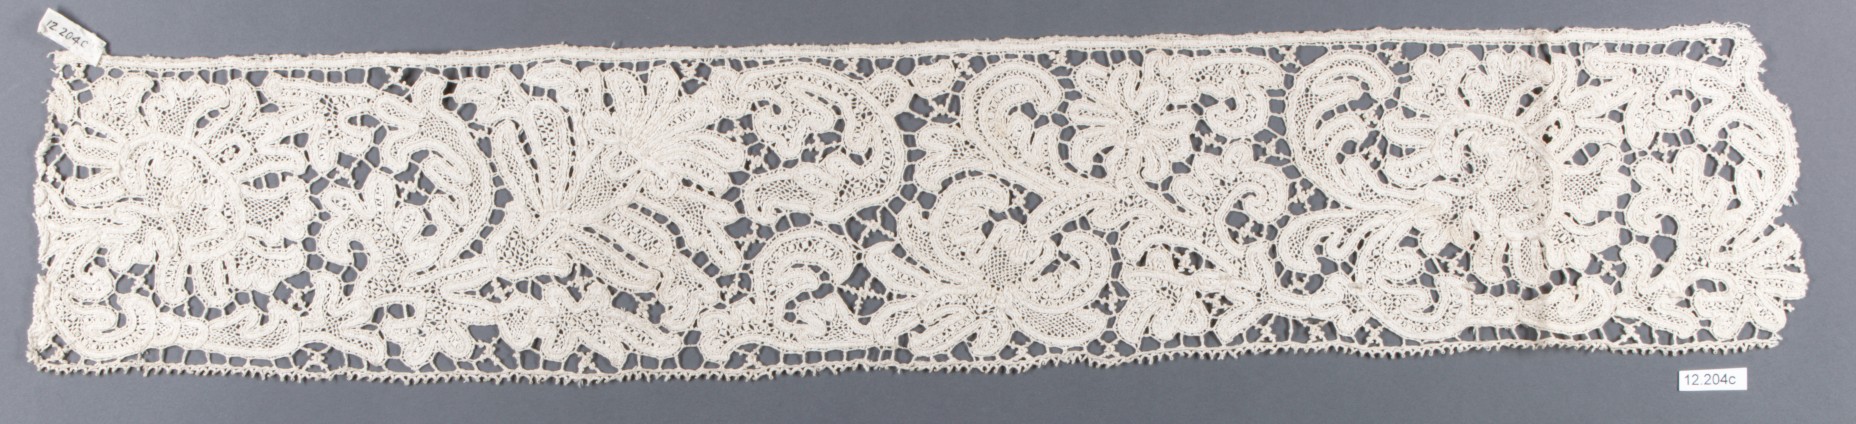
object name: strip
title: Strip (one of two)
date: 1601-1700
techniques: lace